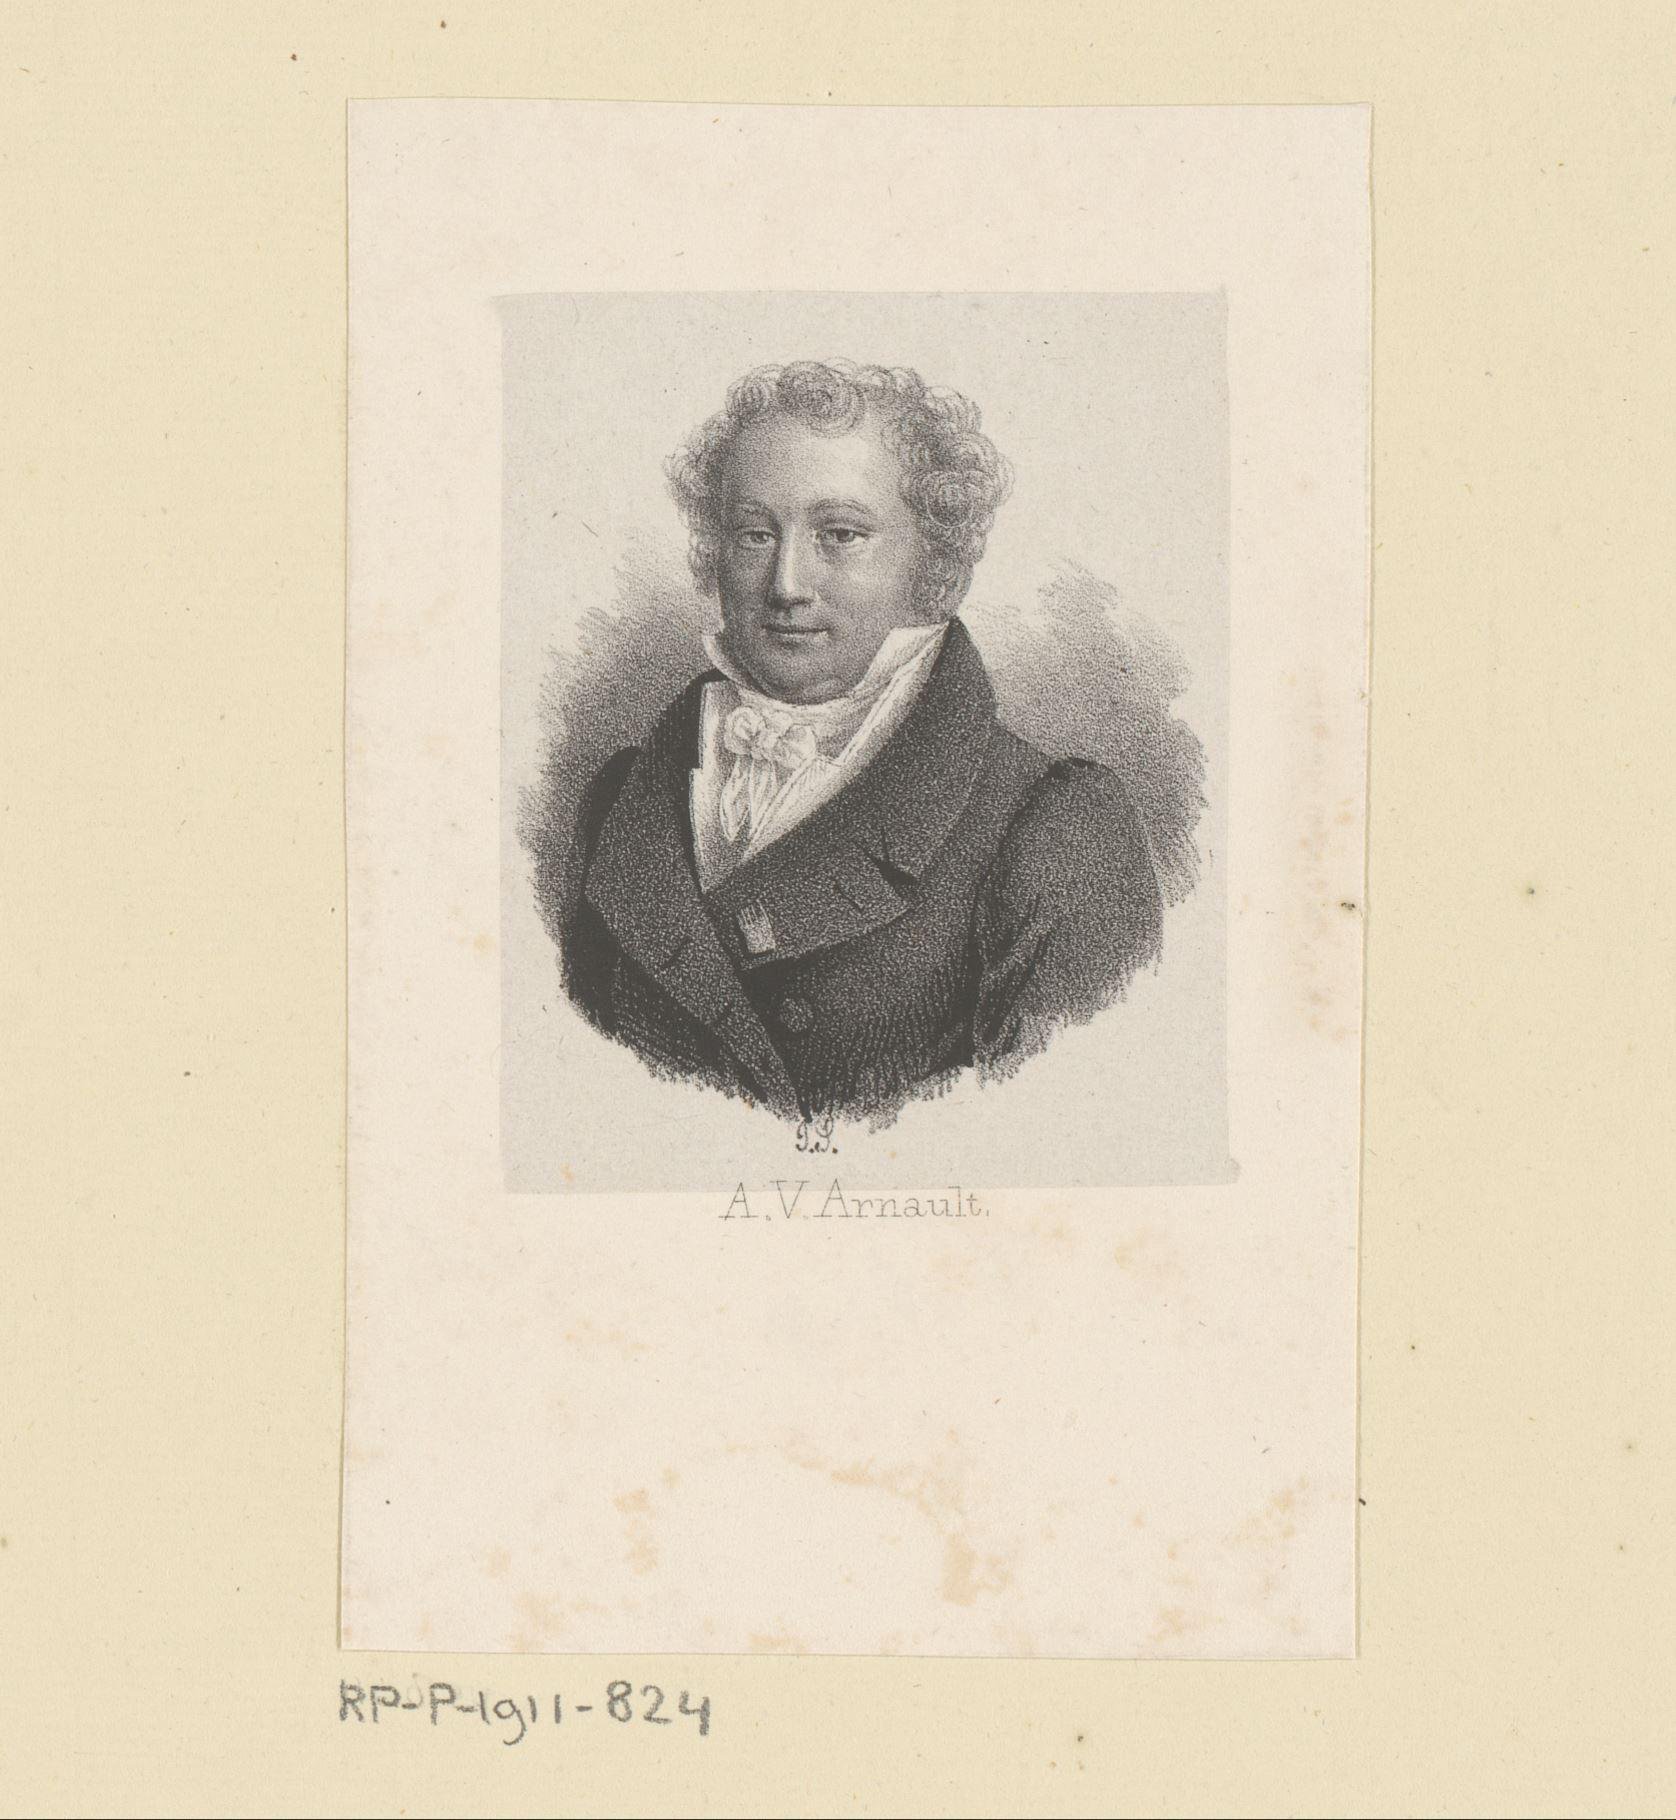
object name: print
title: A.V. Arnault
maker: joseph schubert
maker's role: print maker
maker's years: 1816-1885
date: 1841-1885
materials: paper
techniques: lithograph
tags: paris, politician, historical persons, portrait of a writer, writer, poet, author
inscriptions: collector's mark: Lugt 2228